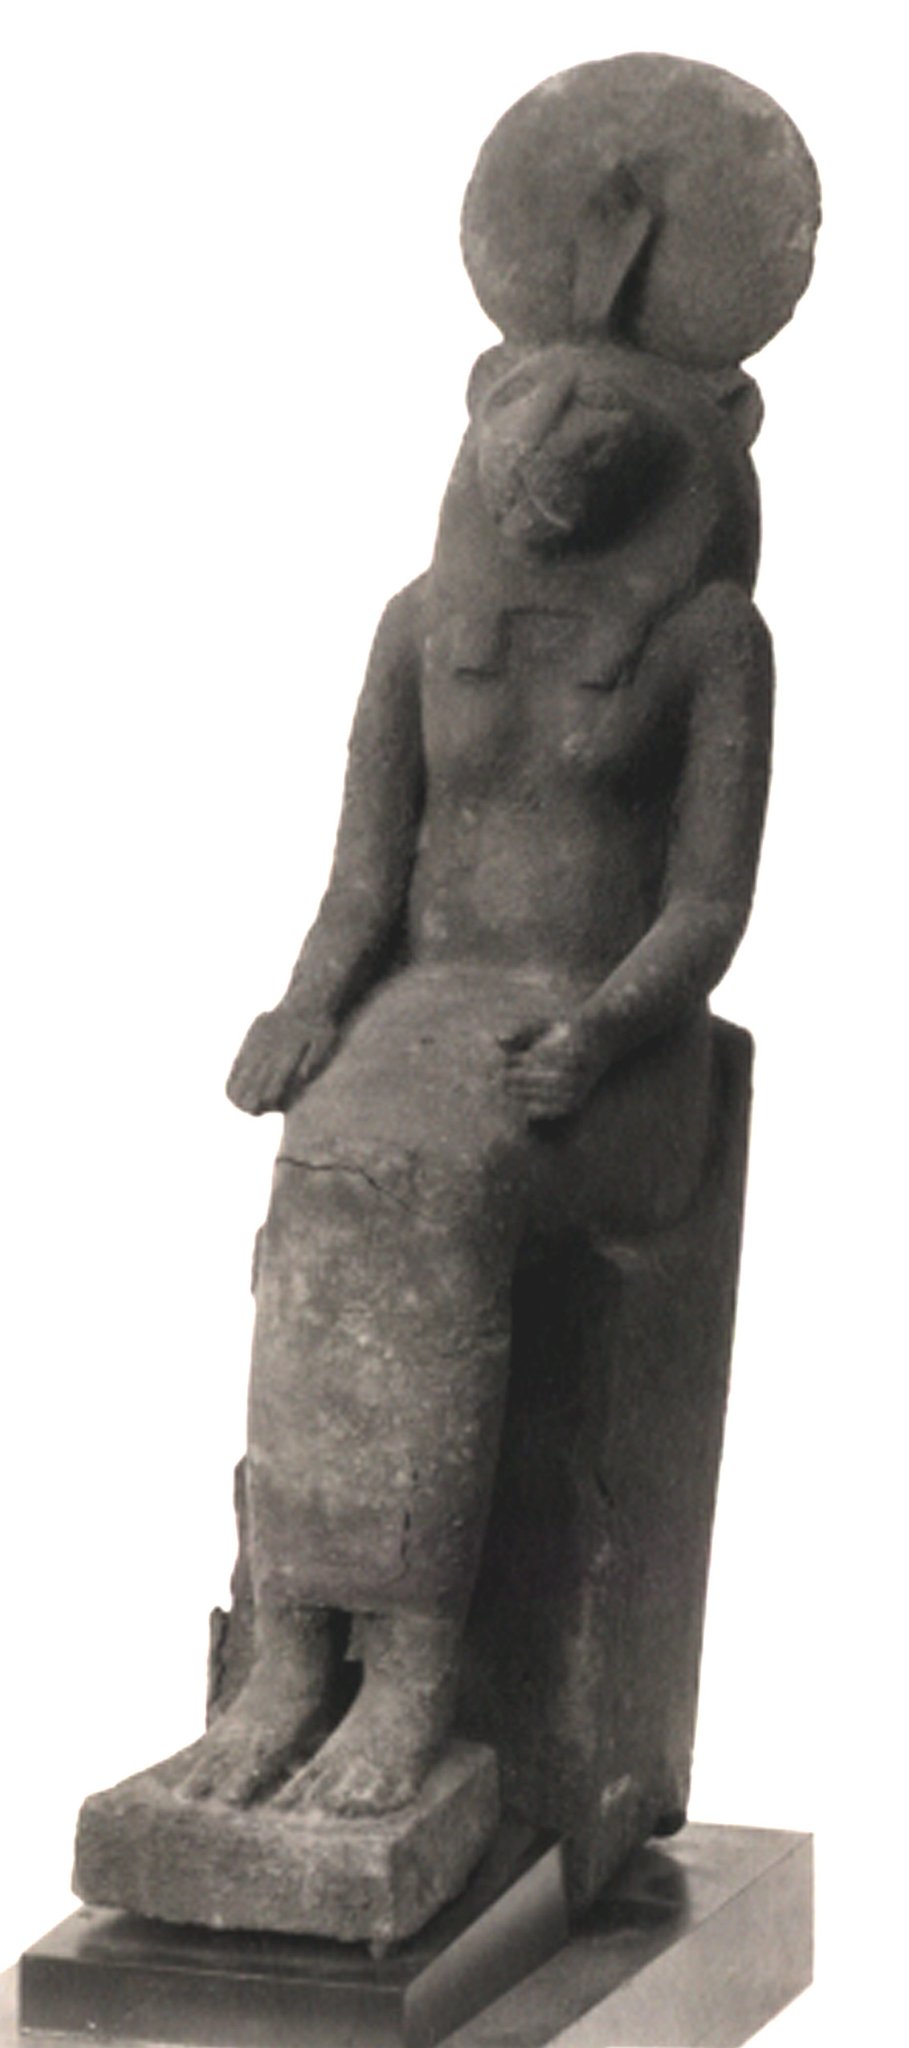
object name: statuette, sakhmet wadjet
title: Statuette, Sakhmet (Wadjet ?)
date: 664-332 BCE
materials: bronze, copper alloy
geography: egypt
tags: goddess